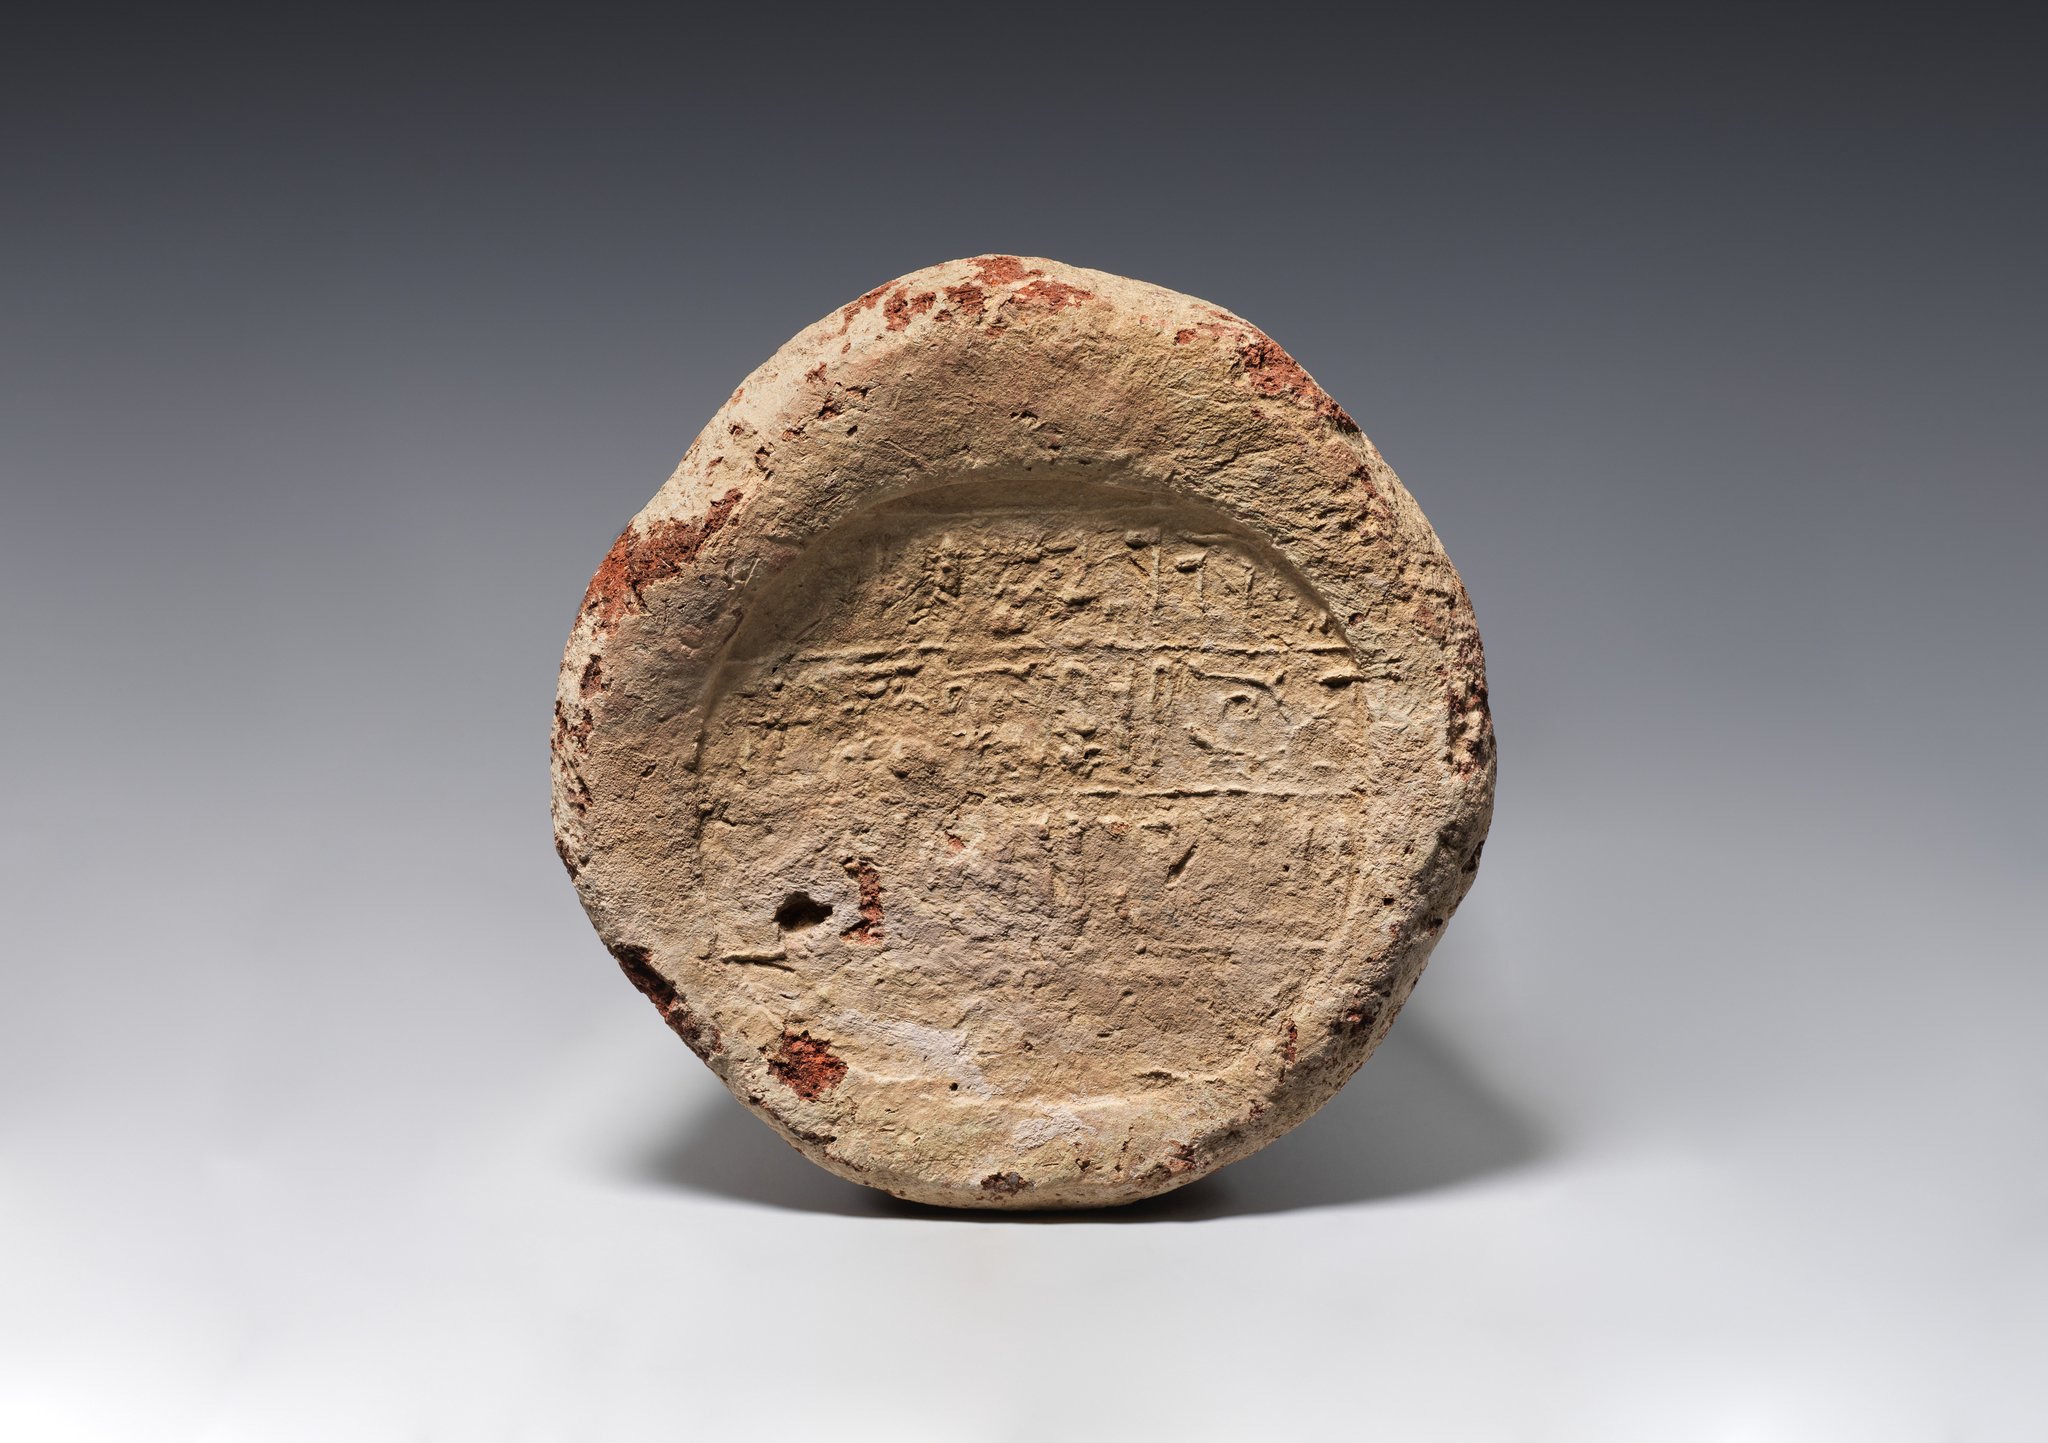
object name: cone, pabasa, tt 279, divine adoratrice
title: Funerary Cone of Pa-ba-sa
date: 712-525 BCE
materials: pottery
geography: egypt